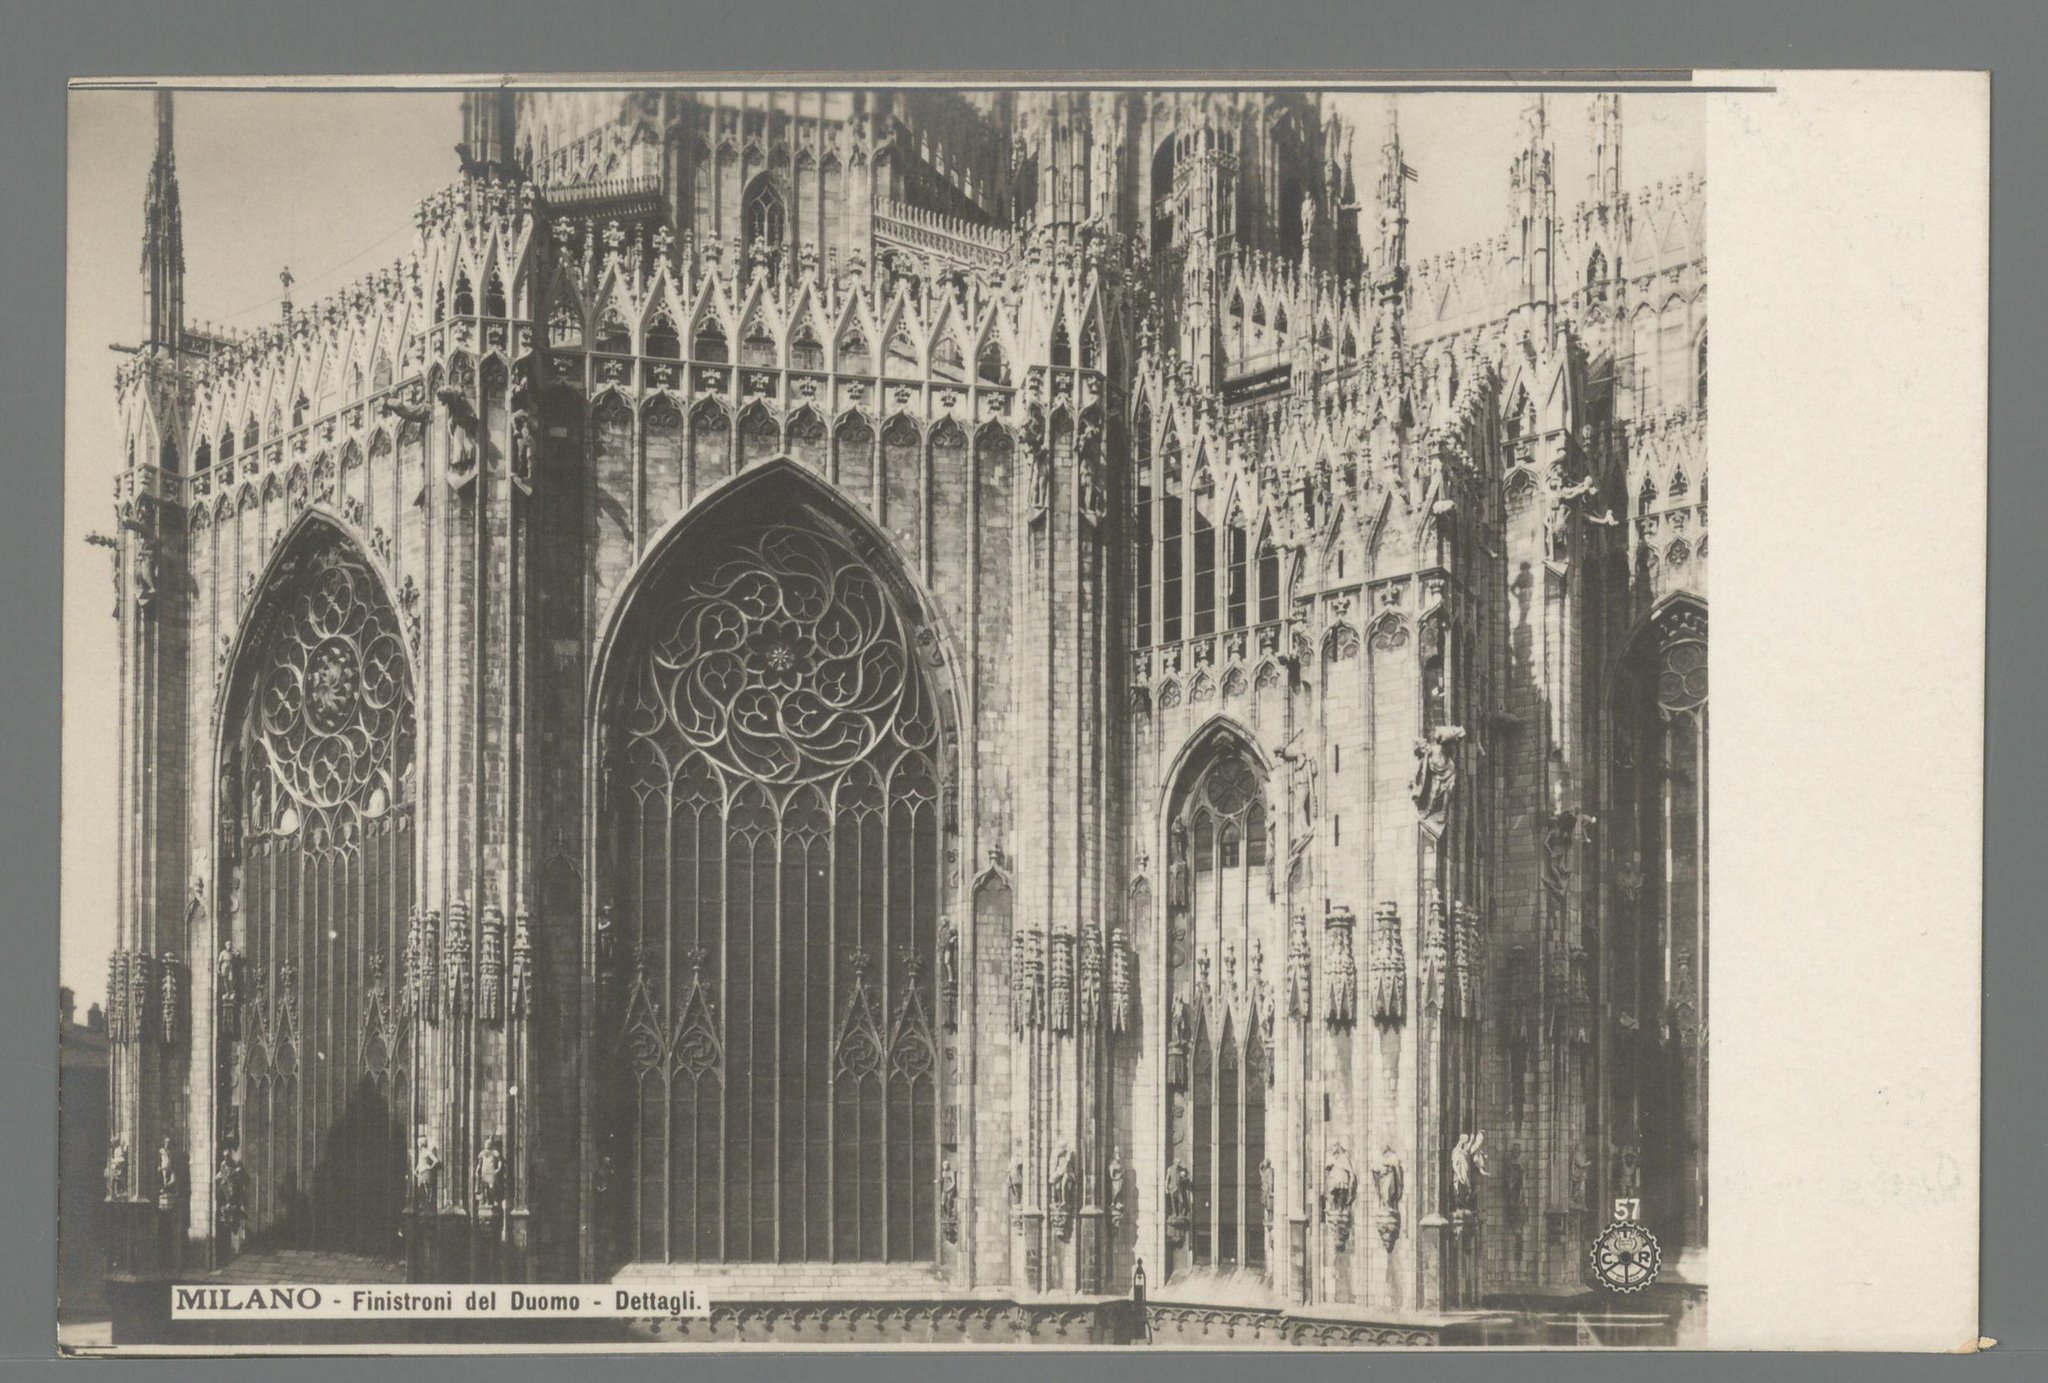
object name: ansichtkaart, prentbriefkaart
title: Milano. Finistroni del Duomo. Dettagli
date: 1900-1906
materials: paper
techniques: gelatin silver print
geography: milan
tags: window, church (exterior)